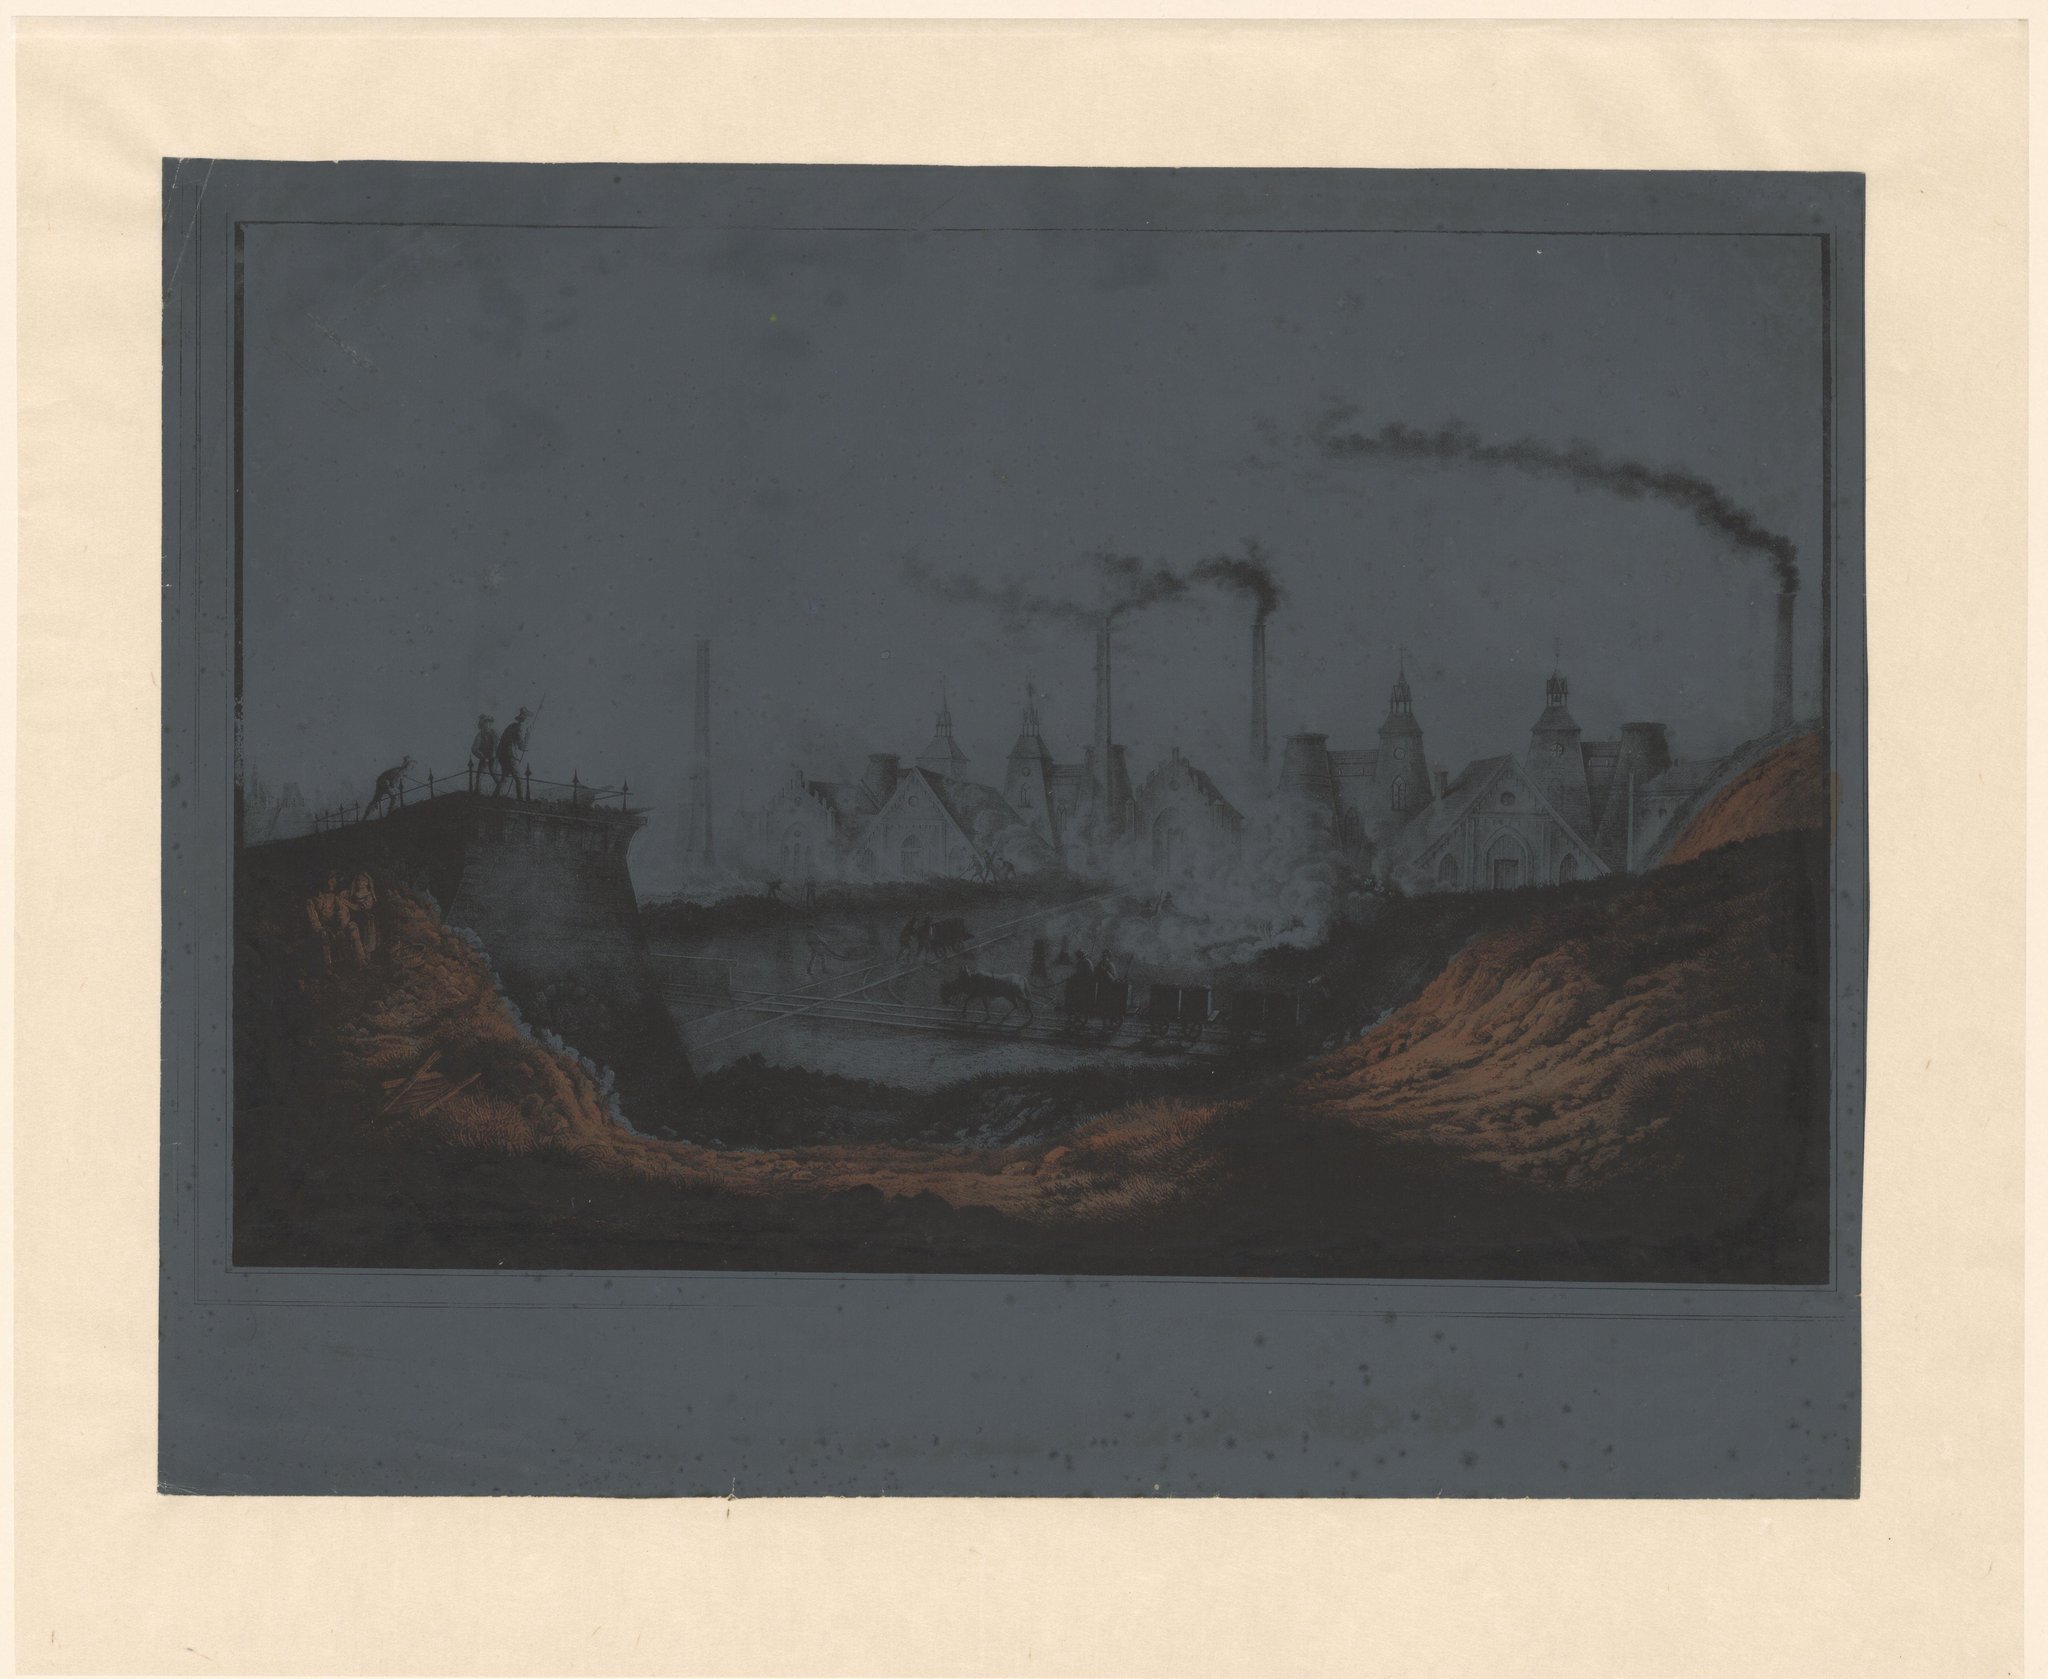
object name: print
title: Kolenfabrieken te Königshütte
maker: Anonymous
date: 1840-1860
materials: gouache, paper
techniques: hand coloring, lithograph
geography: schmiedeberg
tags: smoke-stack, factory-building, crafts and industries (+ men (labourers))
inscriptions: collector's mark: Lugt 2760, collector's mark: Lugt 2228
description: Gezicht op een stad met rokende fabrieksschoorstenen en karren met cokes die over een rails getrokken worden door mensen en paarden. Op de voorgrond rustende mensen.